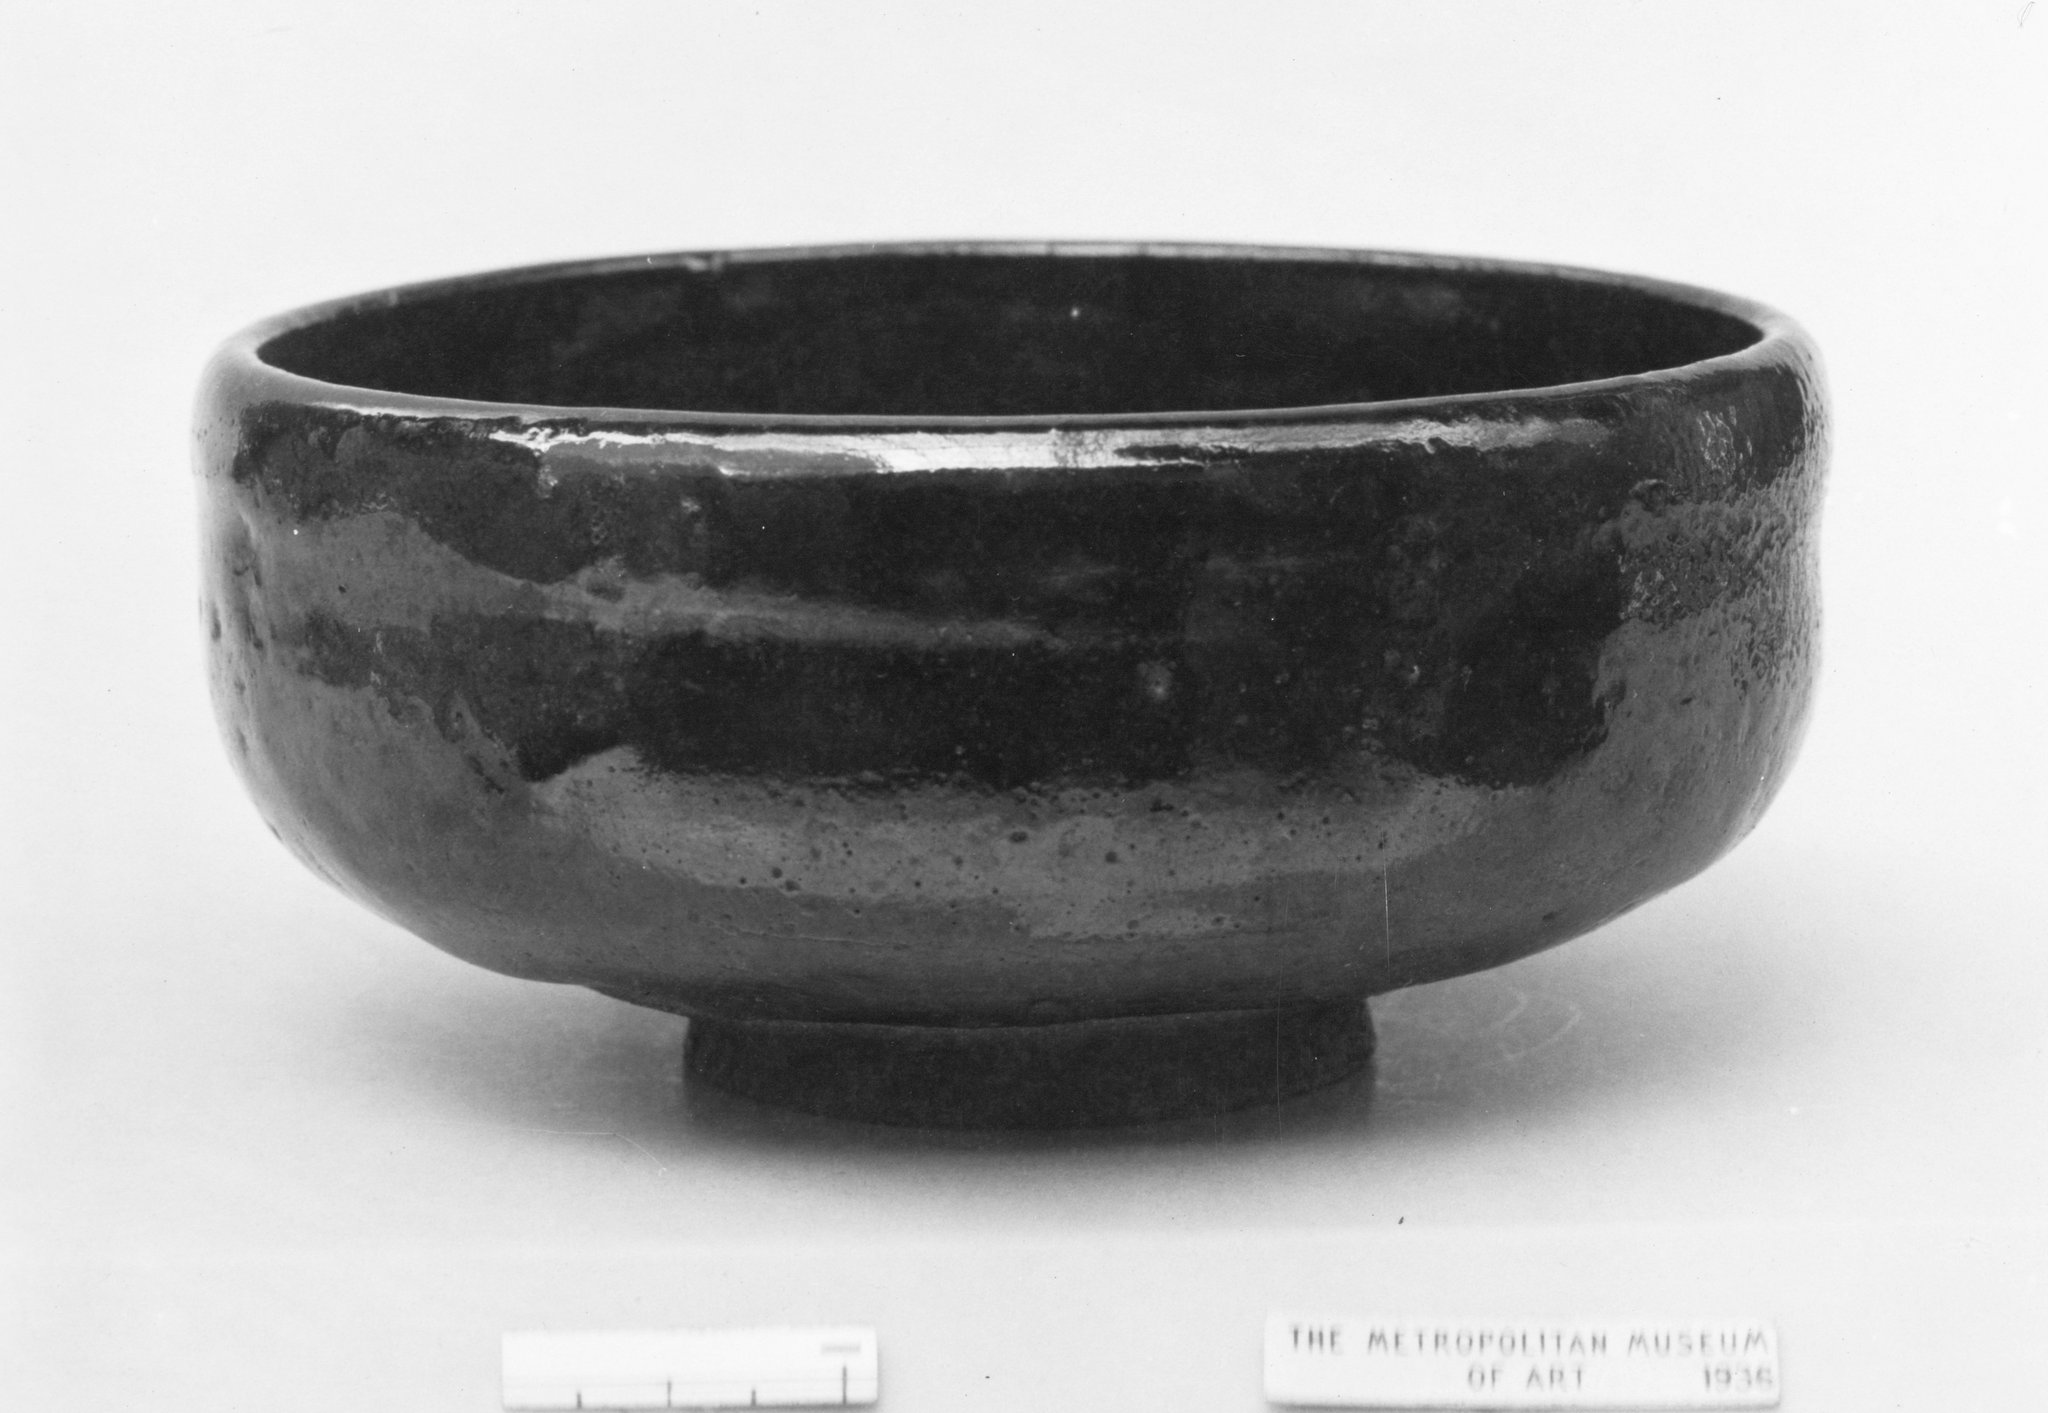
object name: teabowl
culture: japanese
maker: kichizaemon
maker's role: artist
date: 1880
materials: clay, glaze